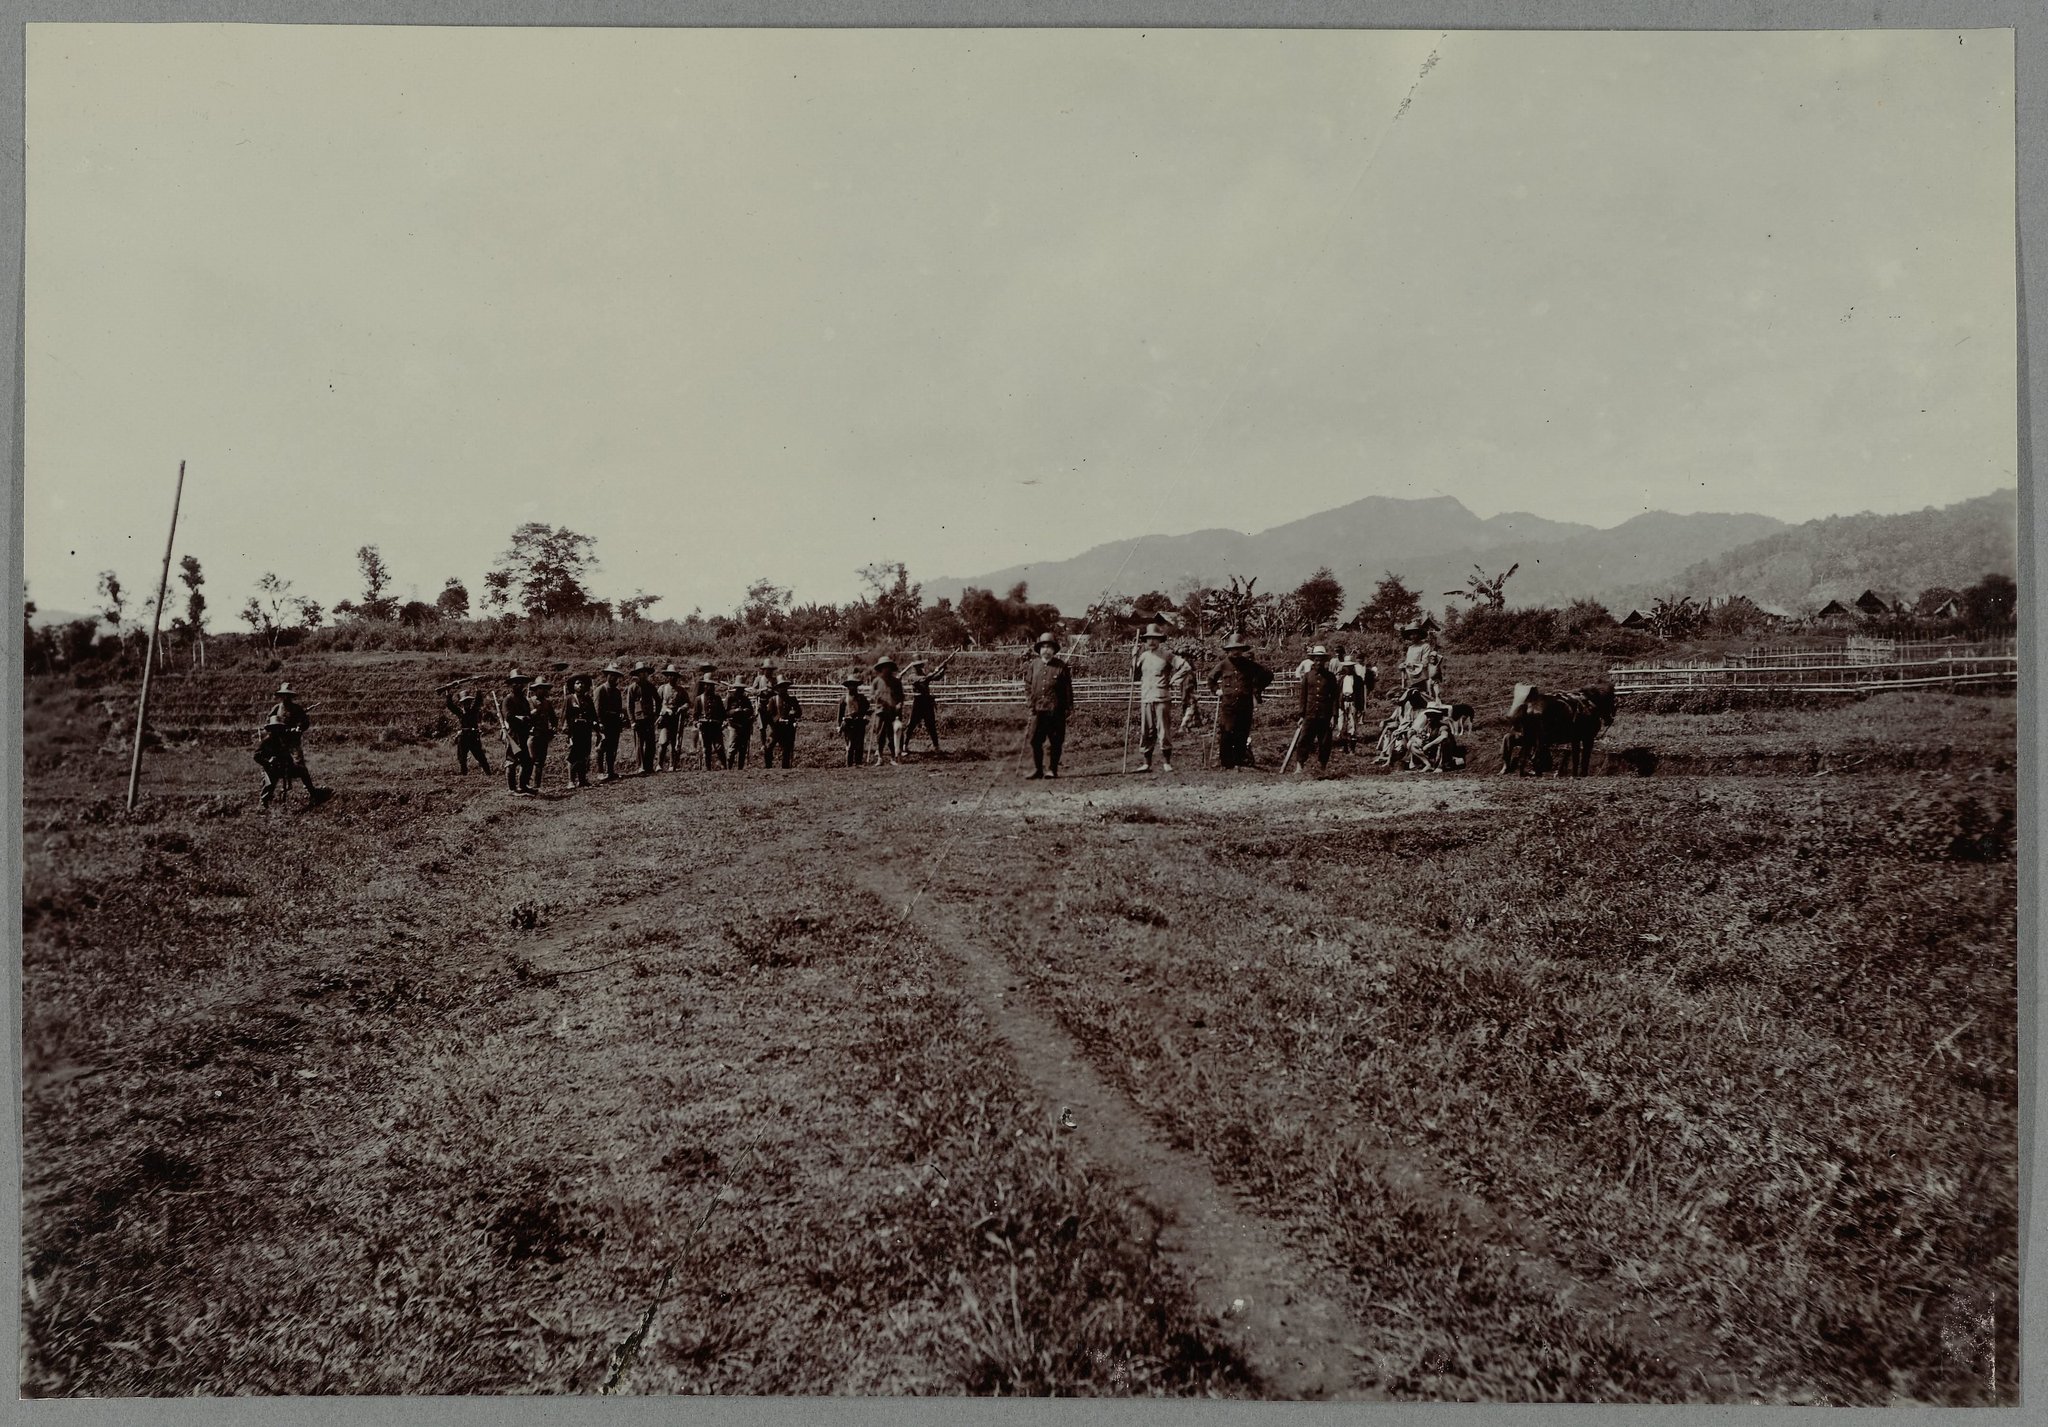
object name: photograph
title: Nederlanders en de militairen bij Bebesan aan het meer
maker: Anonymous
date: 1912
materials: photographic support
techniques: photography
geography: north sumatra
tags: arnhem, albertus dominicus laman trip, landscapes in tropical and sub-tropical regions, lake, road, path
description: Na de expedities naar de Gajo- en Alaslanden o.l.v. Van Daalen (eerste tocht in 1901), werd hij in 1903 belast met voorbereiding van permanente vestiging van Nederlands gezag. Aanleg van een weg van de Noordkust naar het binnenland was hierbij van groot belang. Deze zgn. Gajoweg werd aangelegd tussen 1903 en 1914, van Bireuen aan de kust naar Takinguen aan het bergmeer Danau Lauttawar, totale lente 104 km.